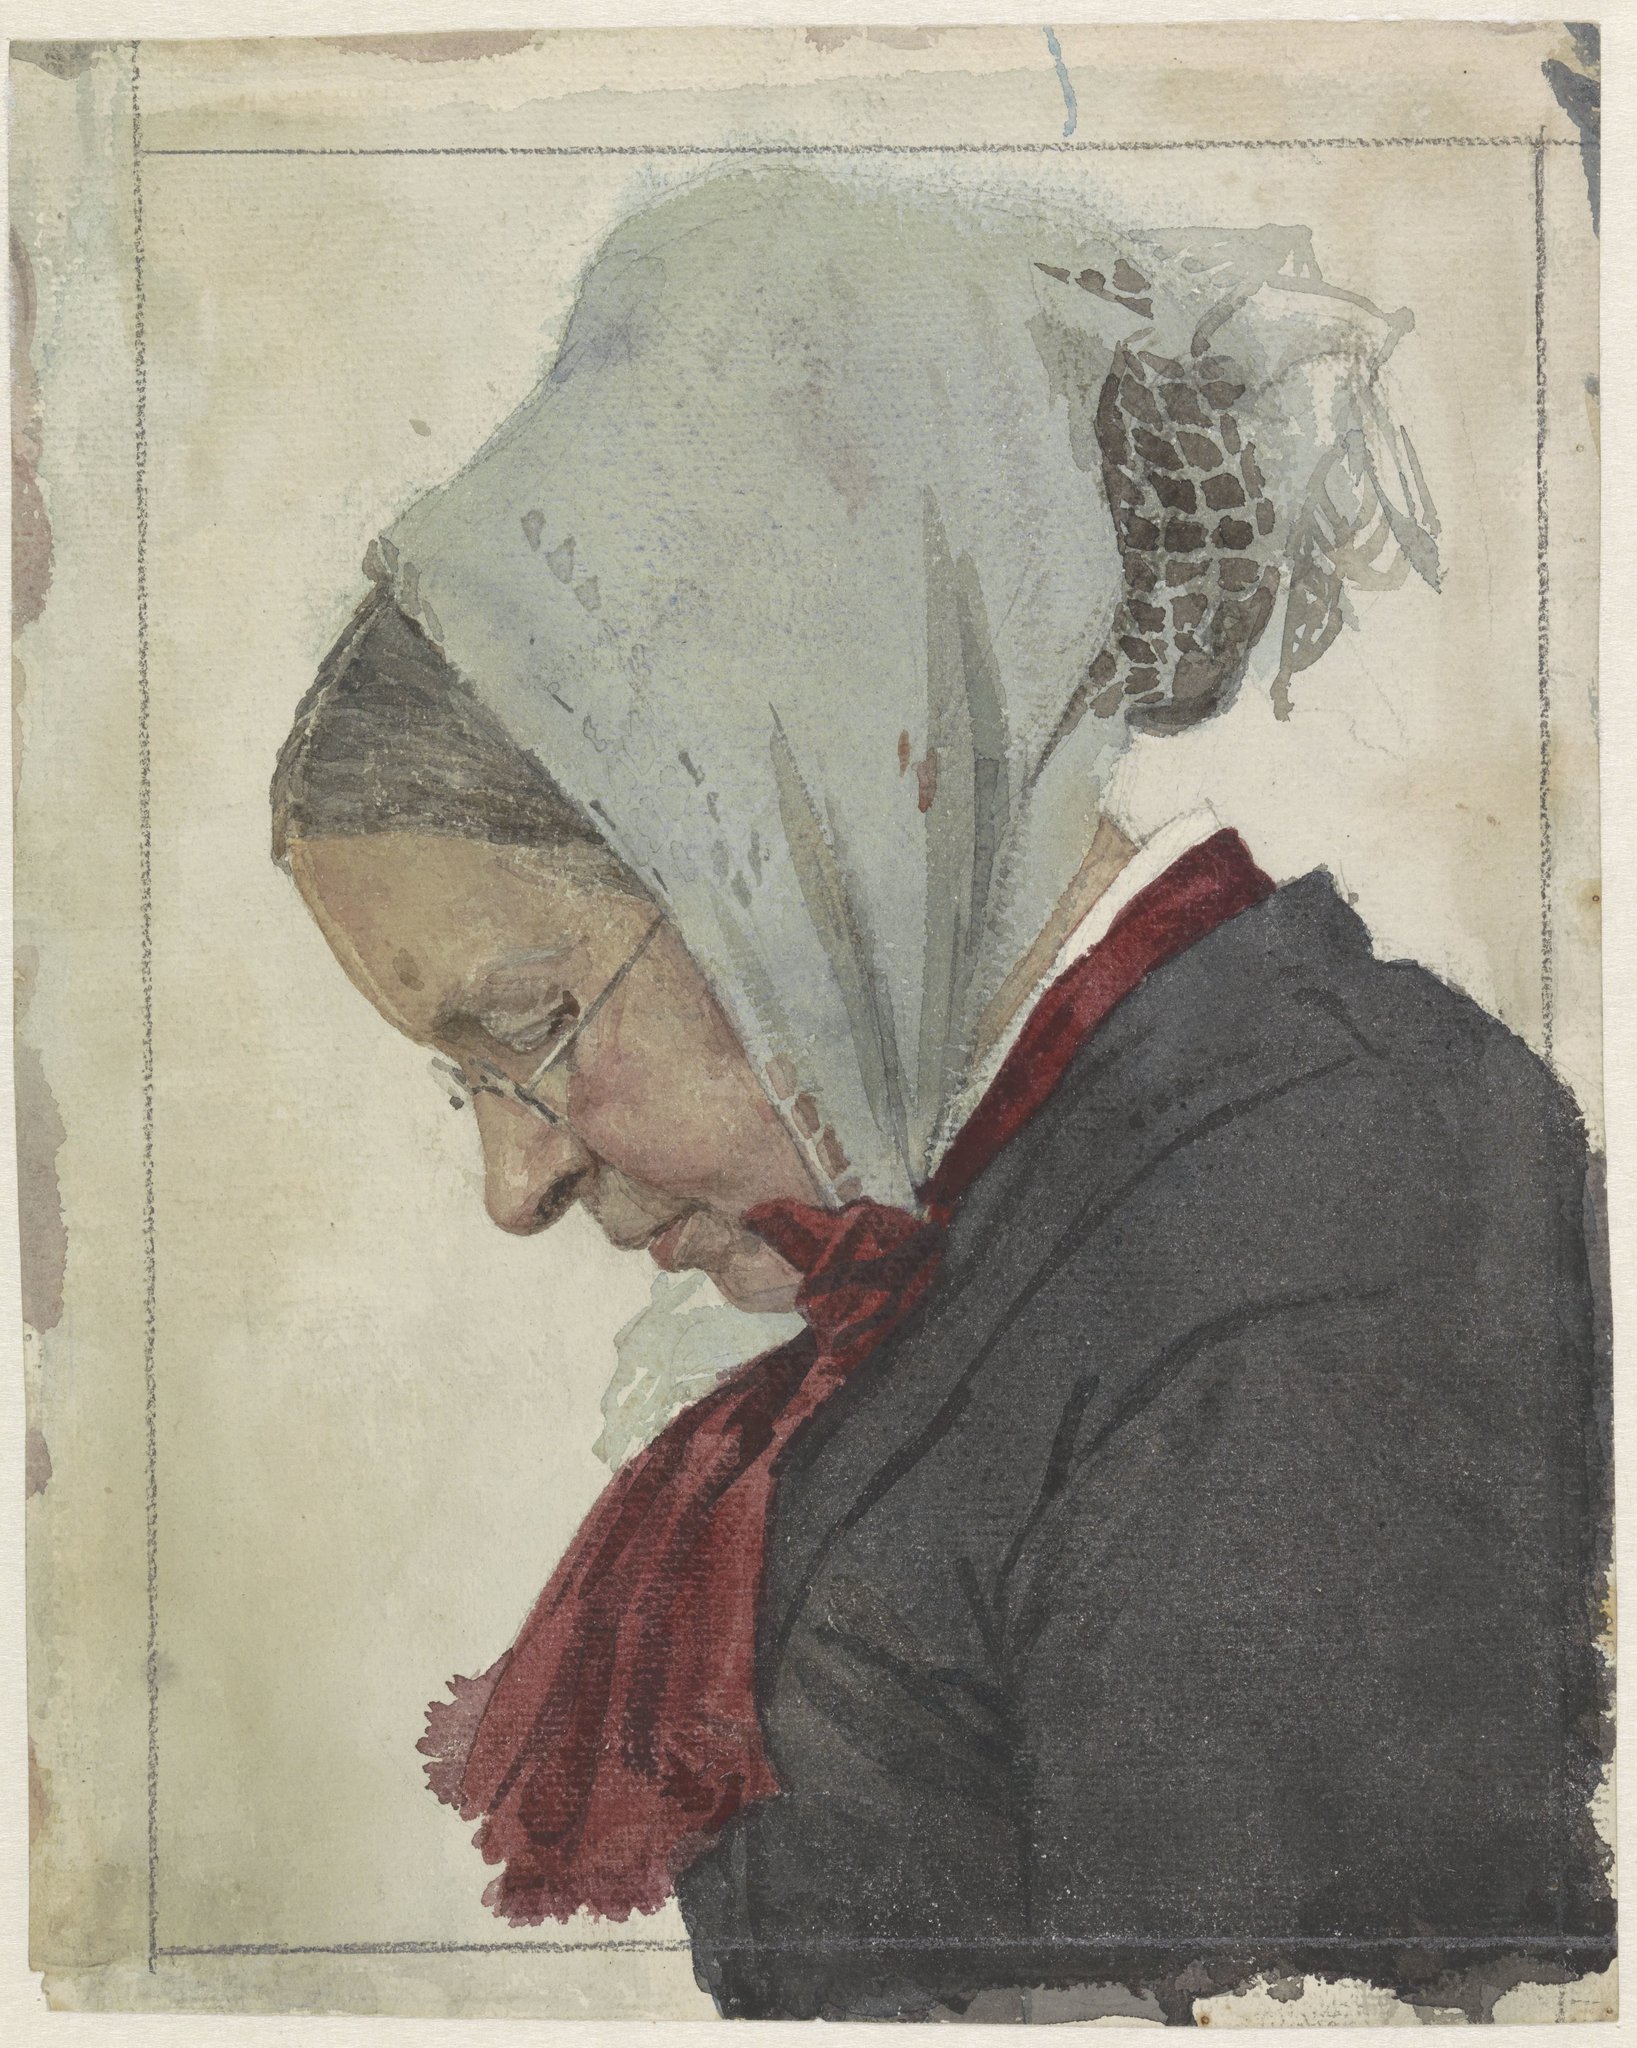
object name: drawing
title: Oude vrouw met hoofddoek en rode sjaal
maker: jan veth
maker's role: designer, draughtsman, painter, print maker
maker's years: 1864-1925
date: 1874-1925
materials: paper, pencil, watercolor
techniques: brush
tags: anonymous historical person portrayed alone